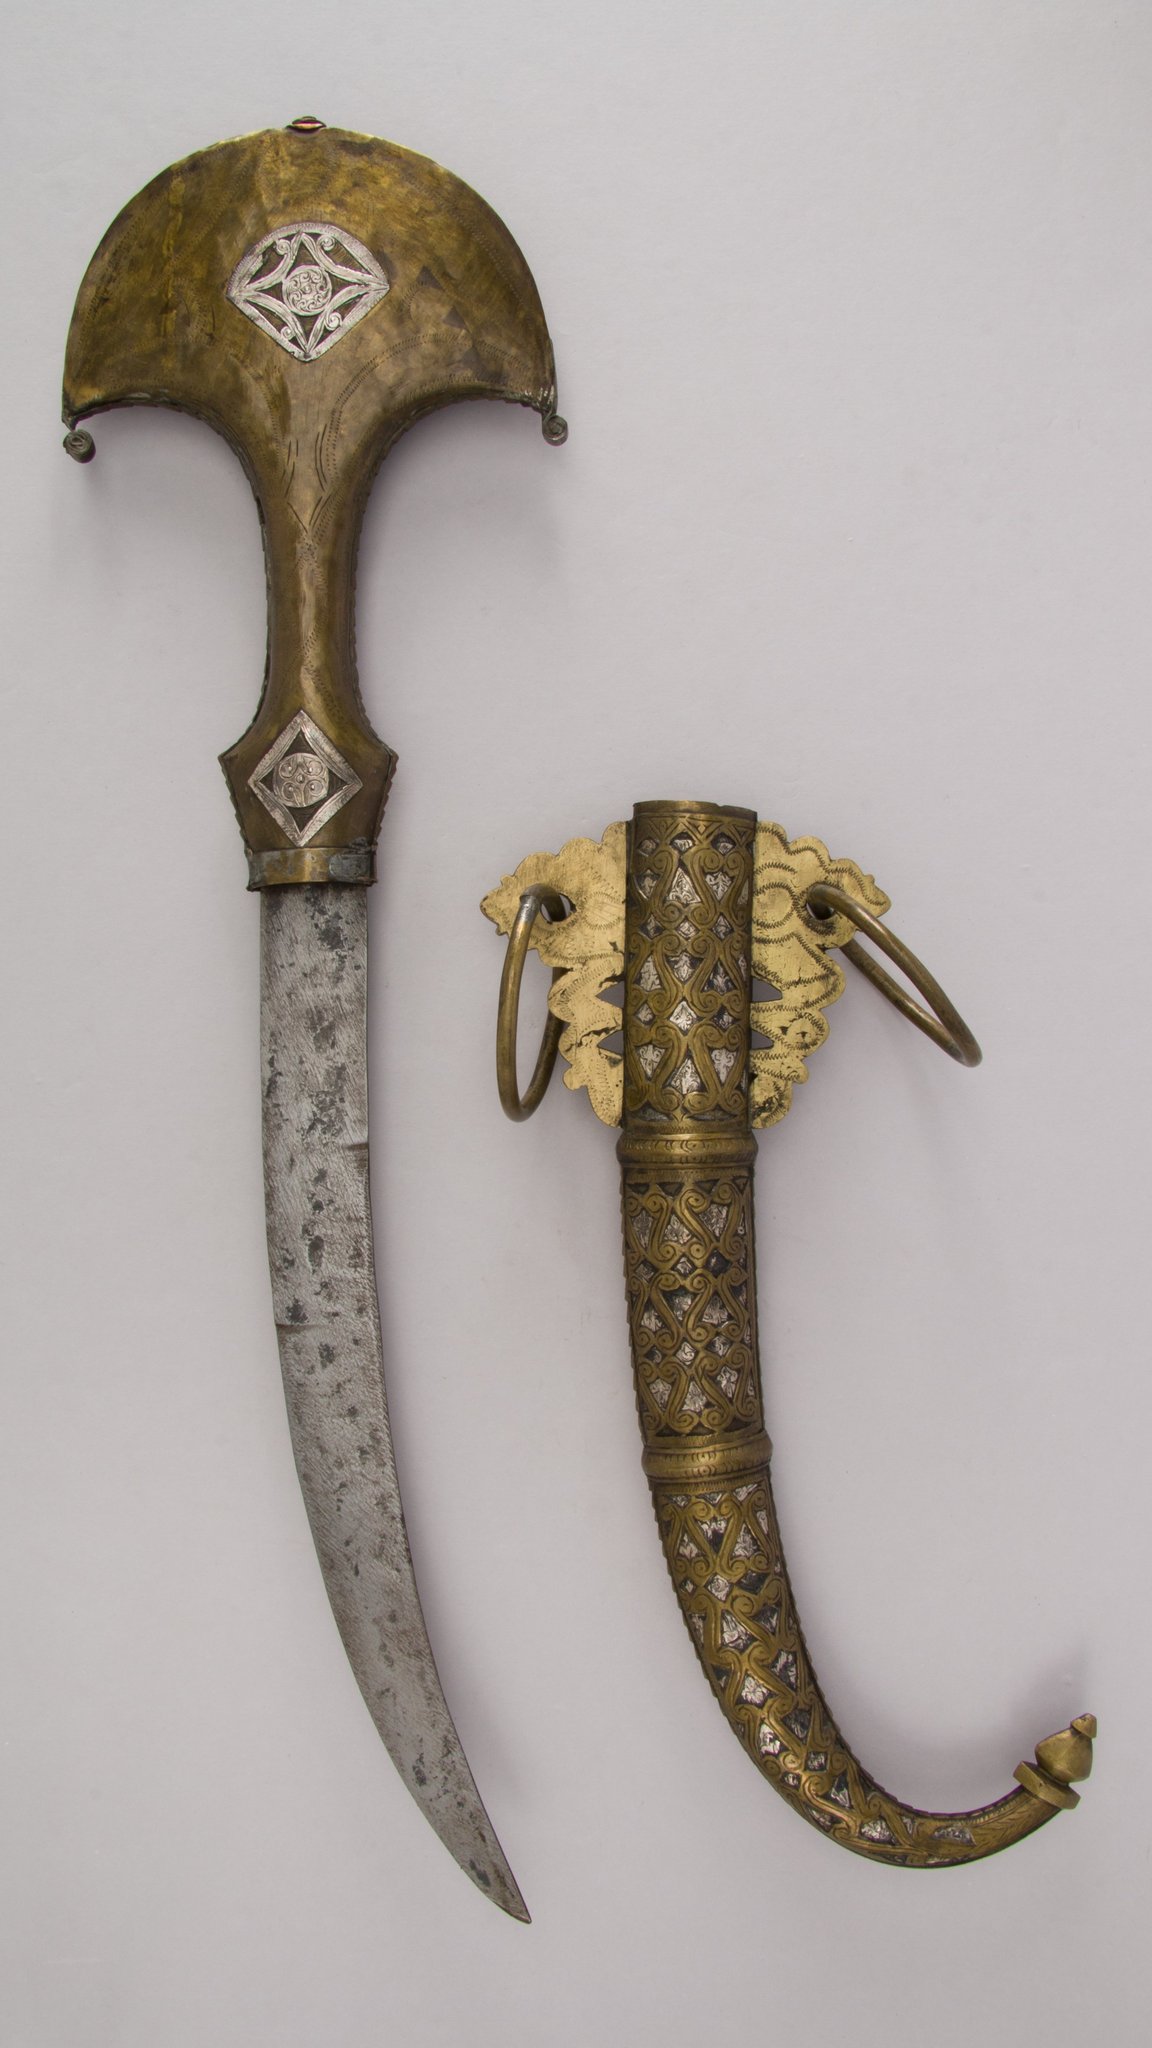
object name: dagger jambiya with sheath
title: Dagger (Jambiya) with Sheath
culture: south moroccan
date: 1701-1900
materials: brass, silver, steel, wood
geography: morocco